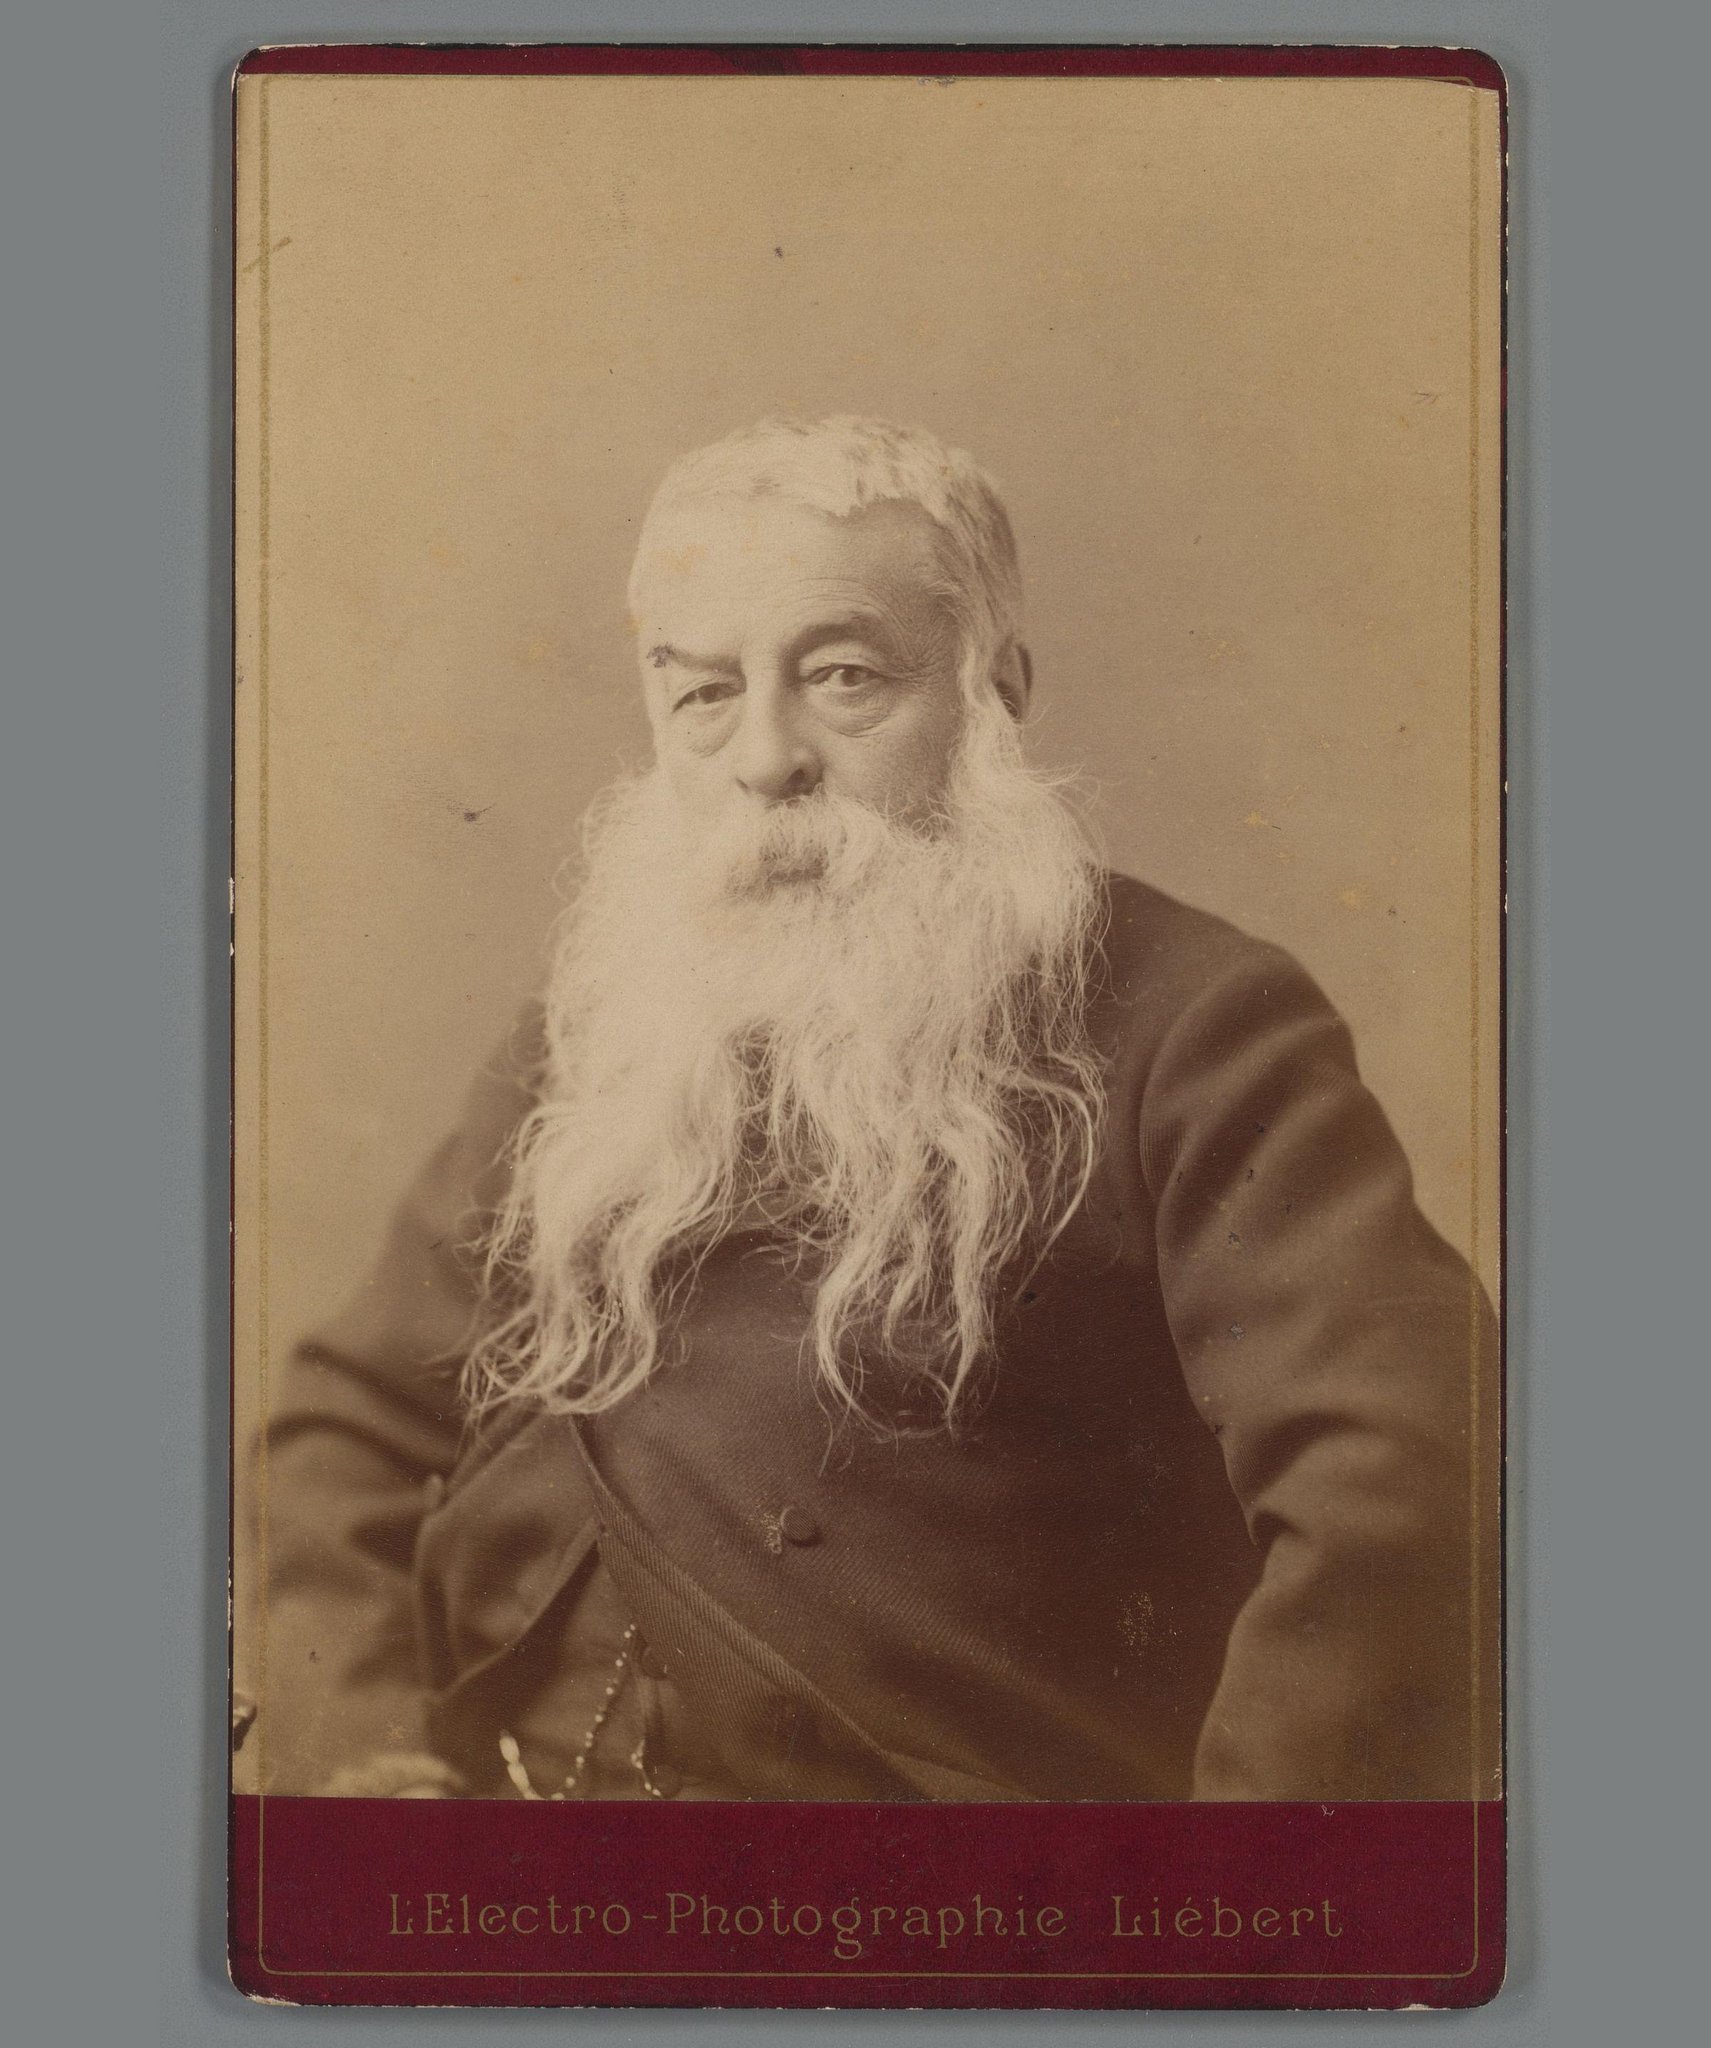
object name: cabinet photograph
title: Portret van de schilder Jean Louis Ernest Meissonnier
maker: alphonse-justin liébert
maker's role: fotograaf, marinier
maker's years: 1827-1914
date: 1851-1863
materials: cardboard, paper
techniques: albumen print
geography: paris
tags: lyon, paris, print maker, draughtsman, jean louis ernest meissonier, portrait, self-portrait of painter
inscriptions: inscription: ‘L'ELECTRO PHOTOGRAPHIE/ LIEBERT/ 7. rue de Clichy, 7/ SUCCURSALE A/ Salons de pose au rez-de-chaussée/ D. HUTINET-PARIS’